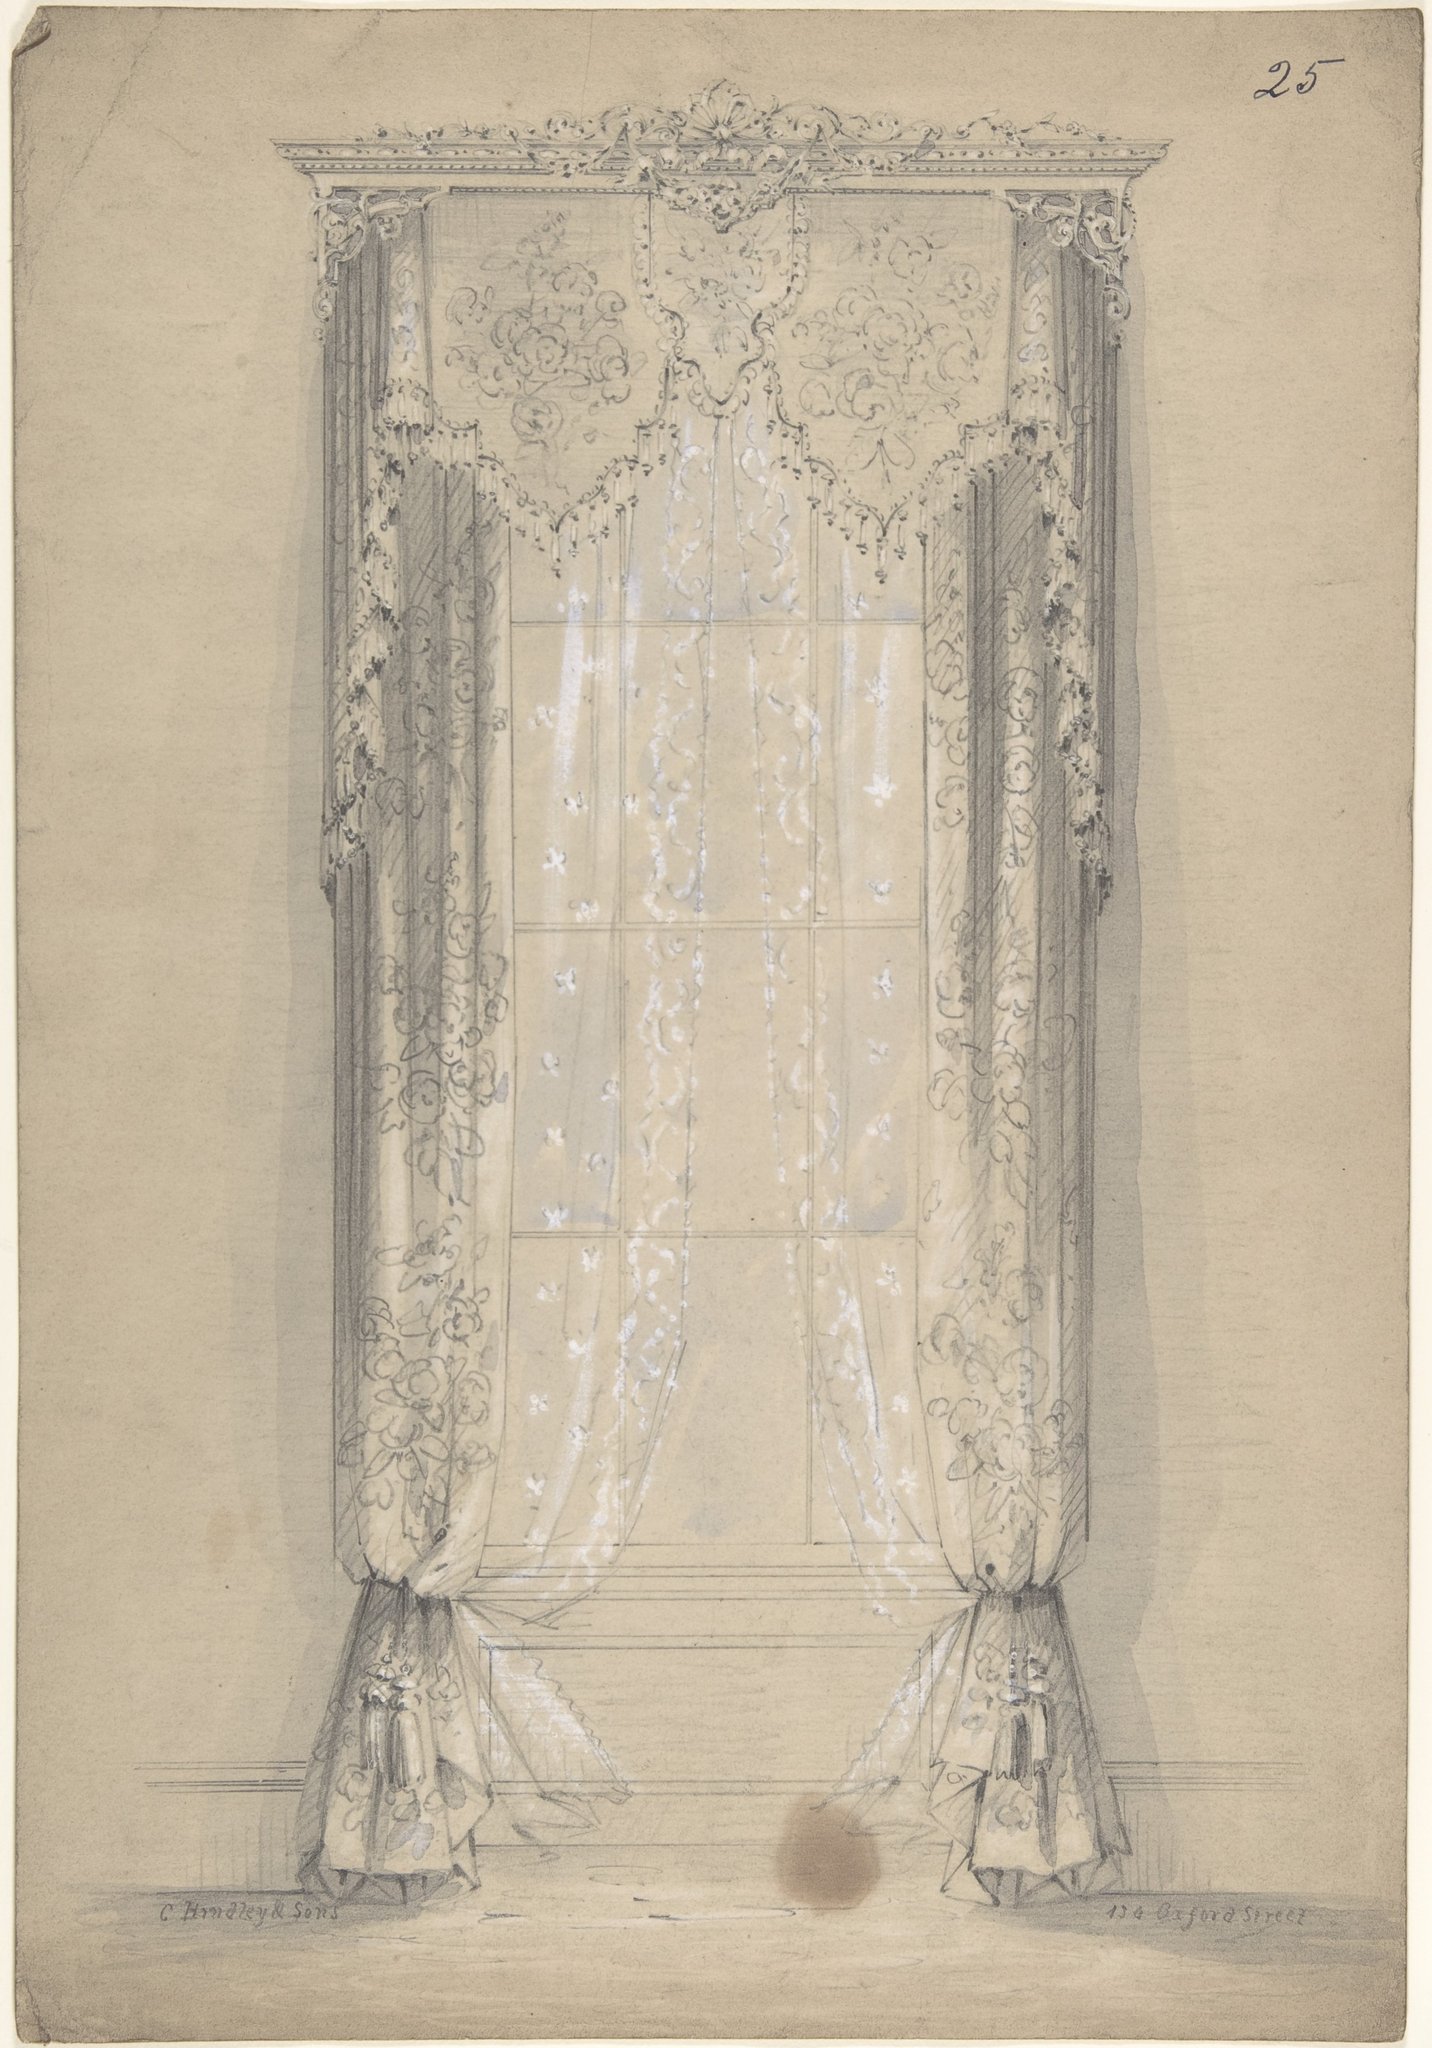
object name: drawing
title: Design for Curtains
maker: charles hindley and sons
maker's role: artist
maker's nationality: british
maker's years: 1841-1917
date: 1841-1884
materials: gouache, graphite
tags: windows,curtains